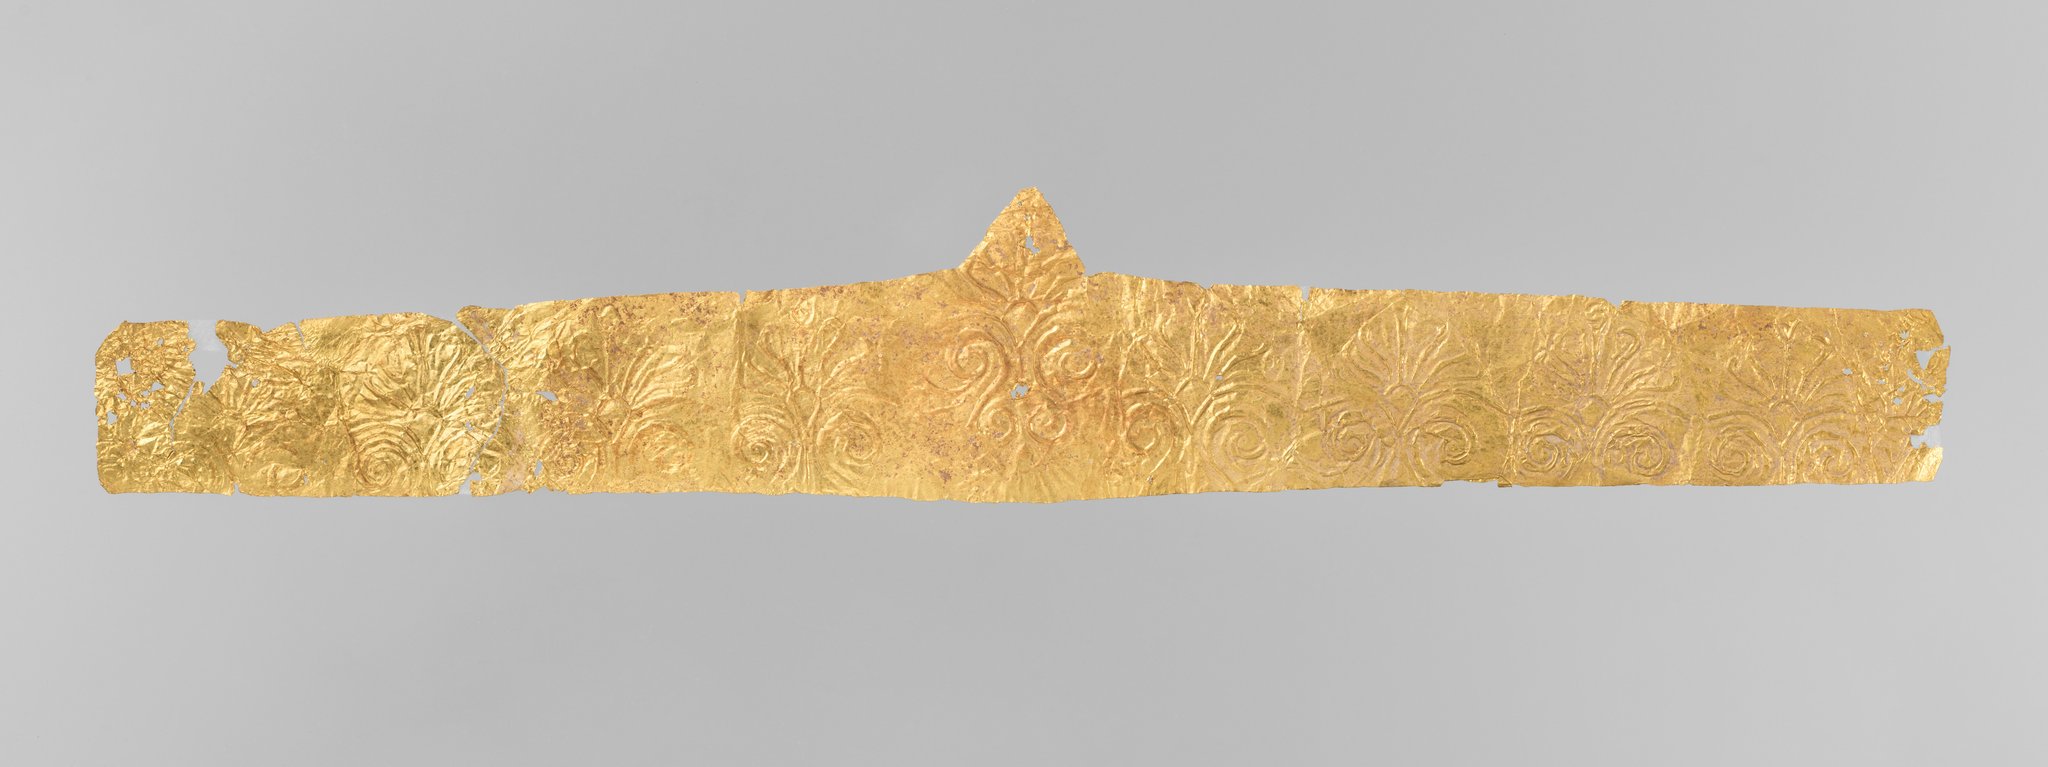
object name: wreath diadem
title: Gold diadem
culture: greek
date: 400-301 BCE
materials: gold